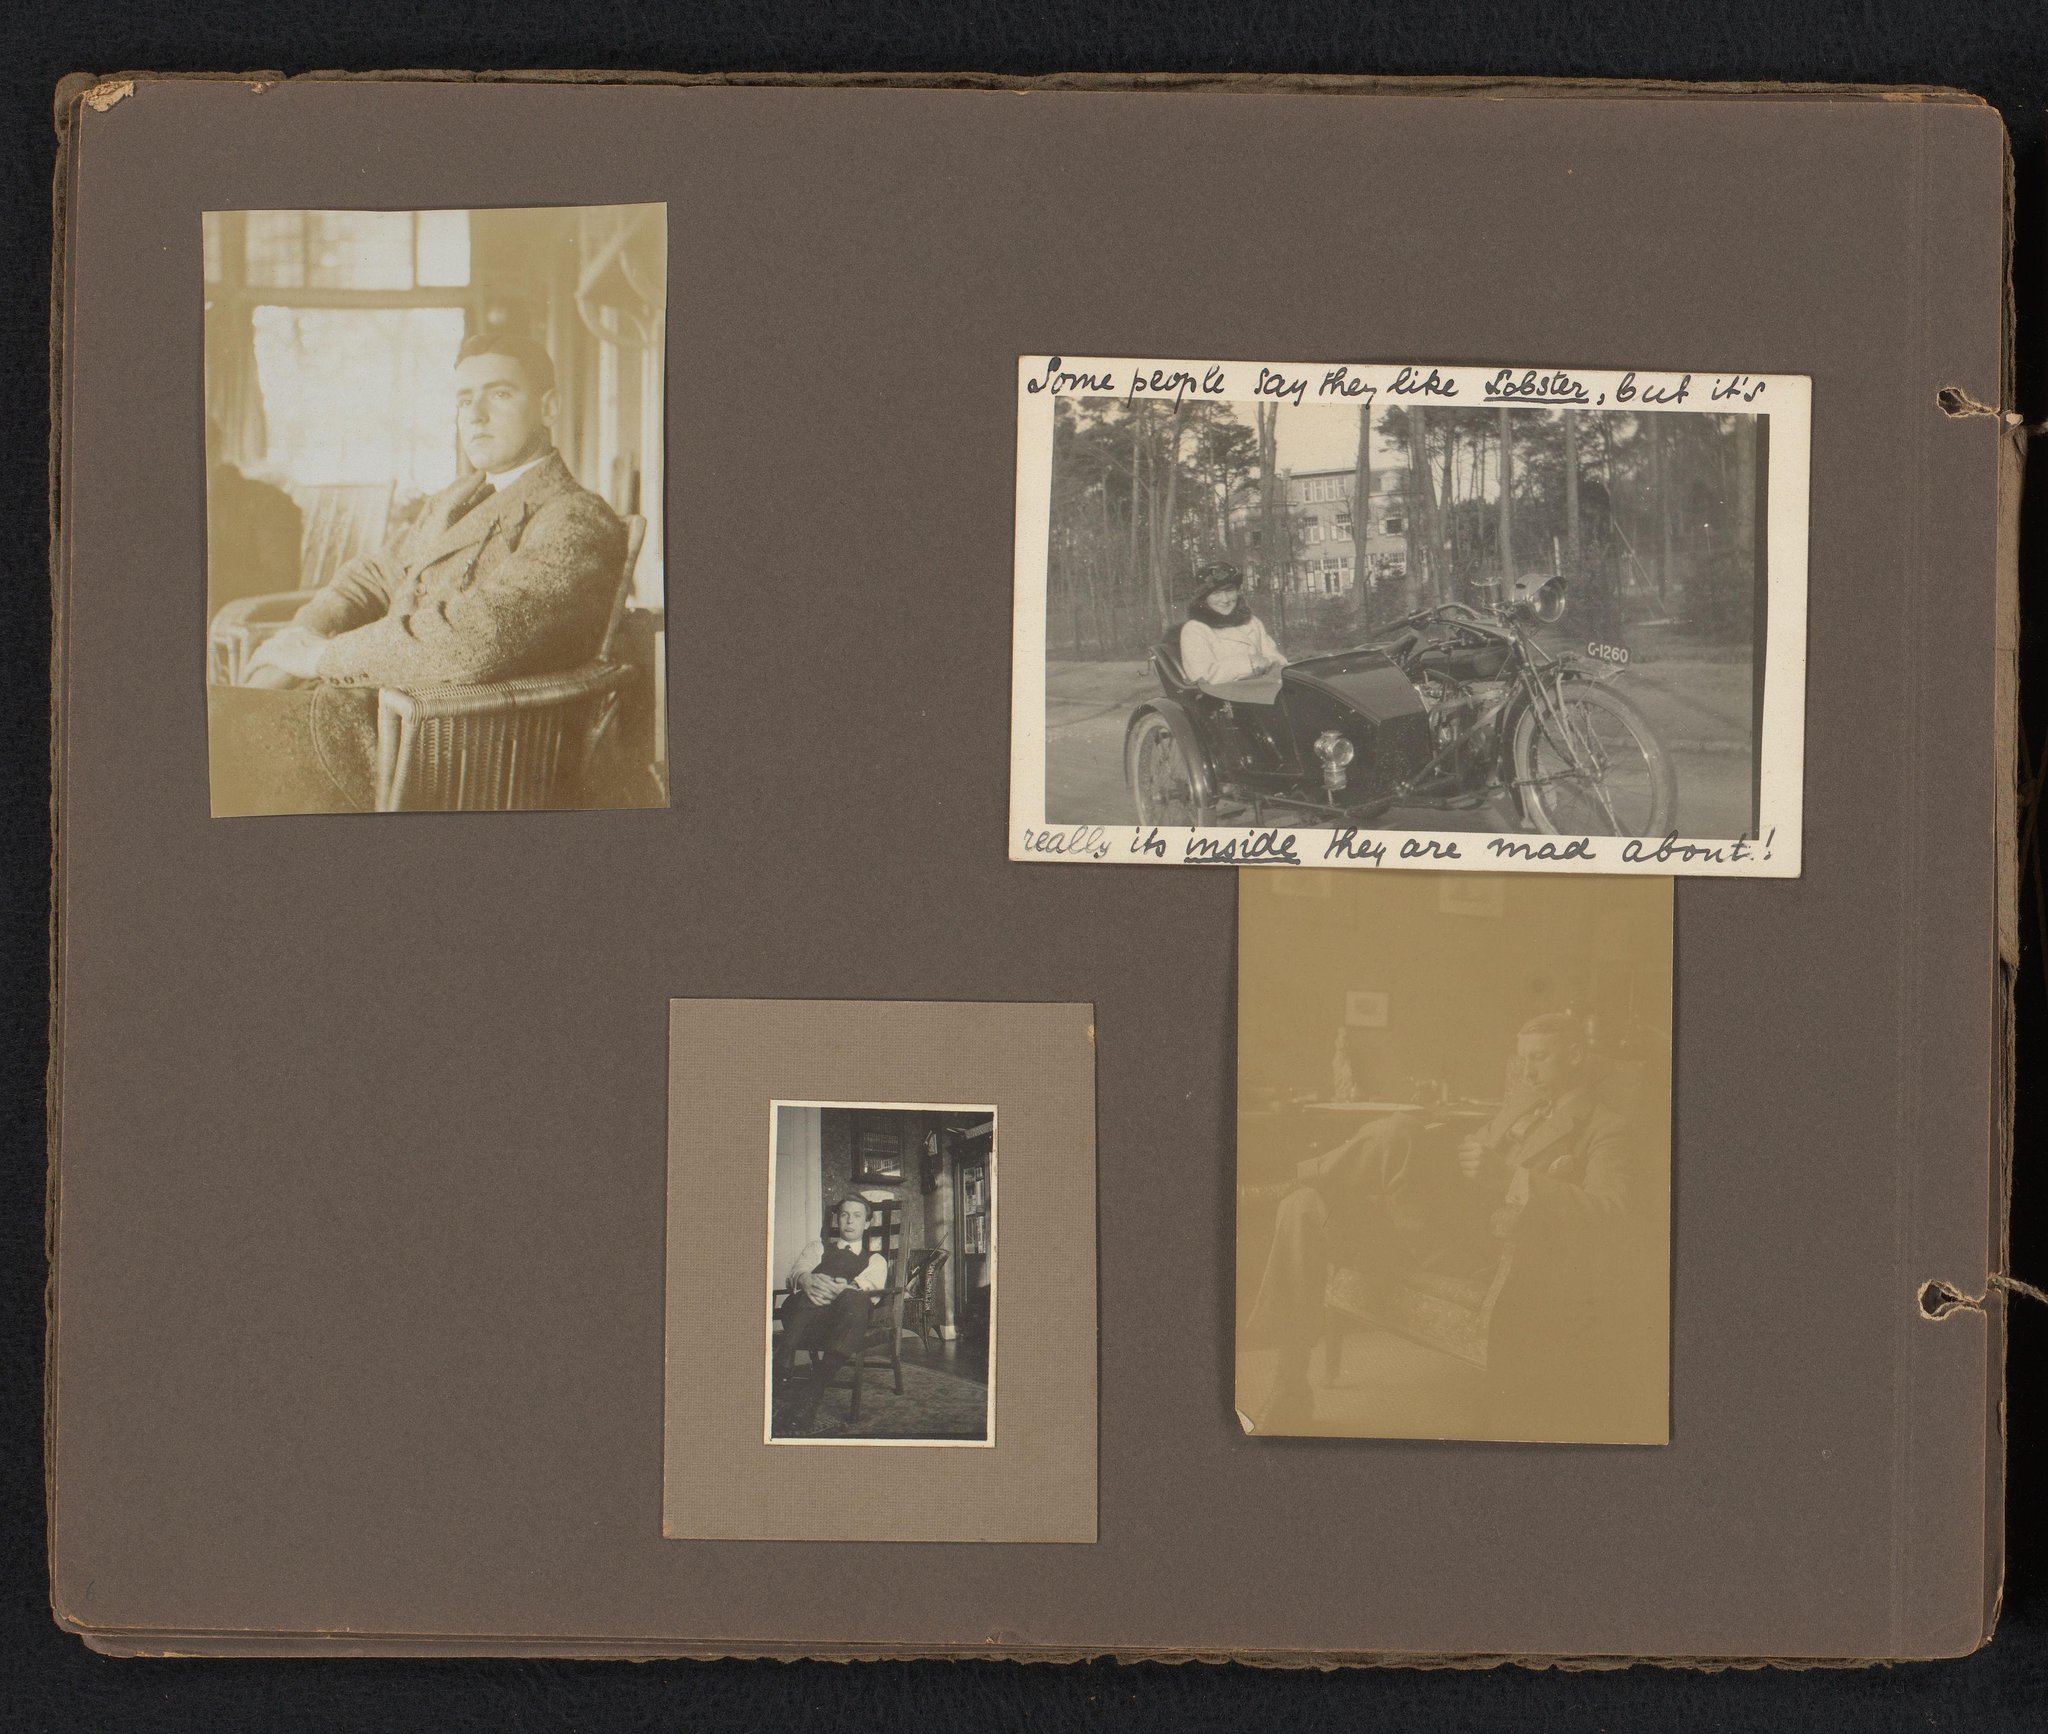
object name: album leaf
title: Vier portretten van vrienden van Loentje Onnen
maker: carolina frederika onnen (lien/loen)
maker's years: 1896-1983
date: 1912-1913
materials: paper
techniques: gelatin silver print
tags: motor-cycles and other two-wheeled motor-vehicles, historical persons not known by name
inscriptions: inscription: ‘Some people say they like Lobster, but it's/ really its inside they are mad about!’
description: Deze foto's maken deel uit van een album.